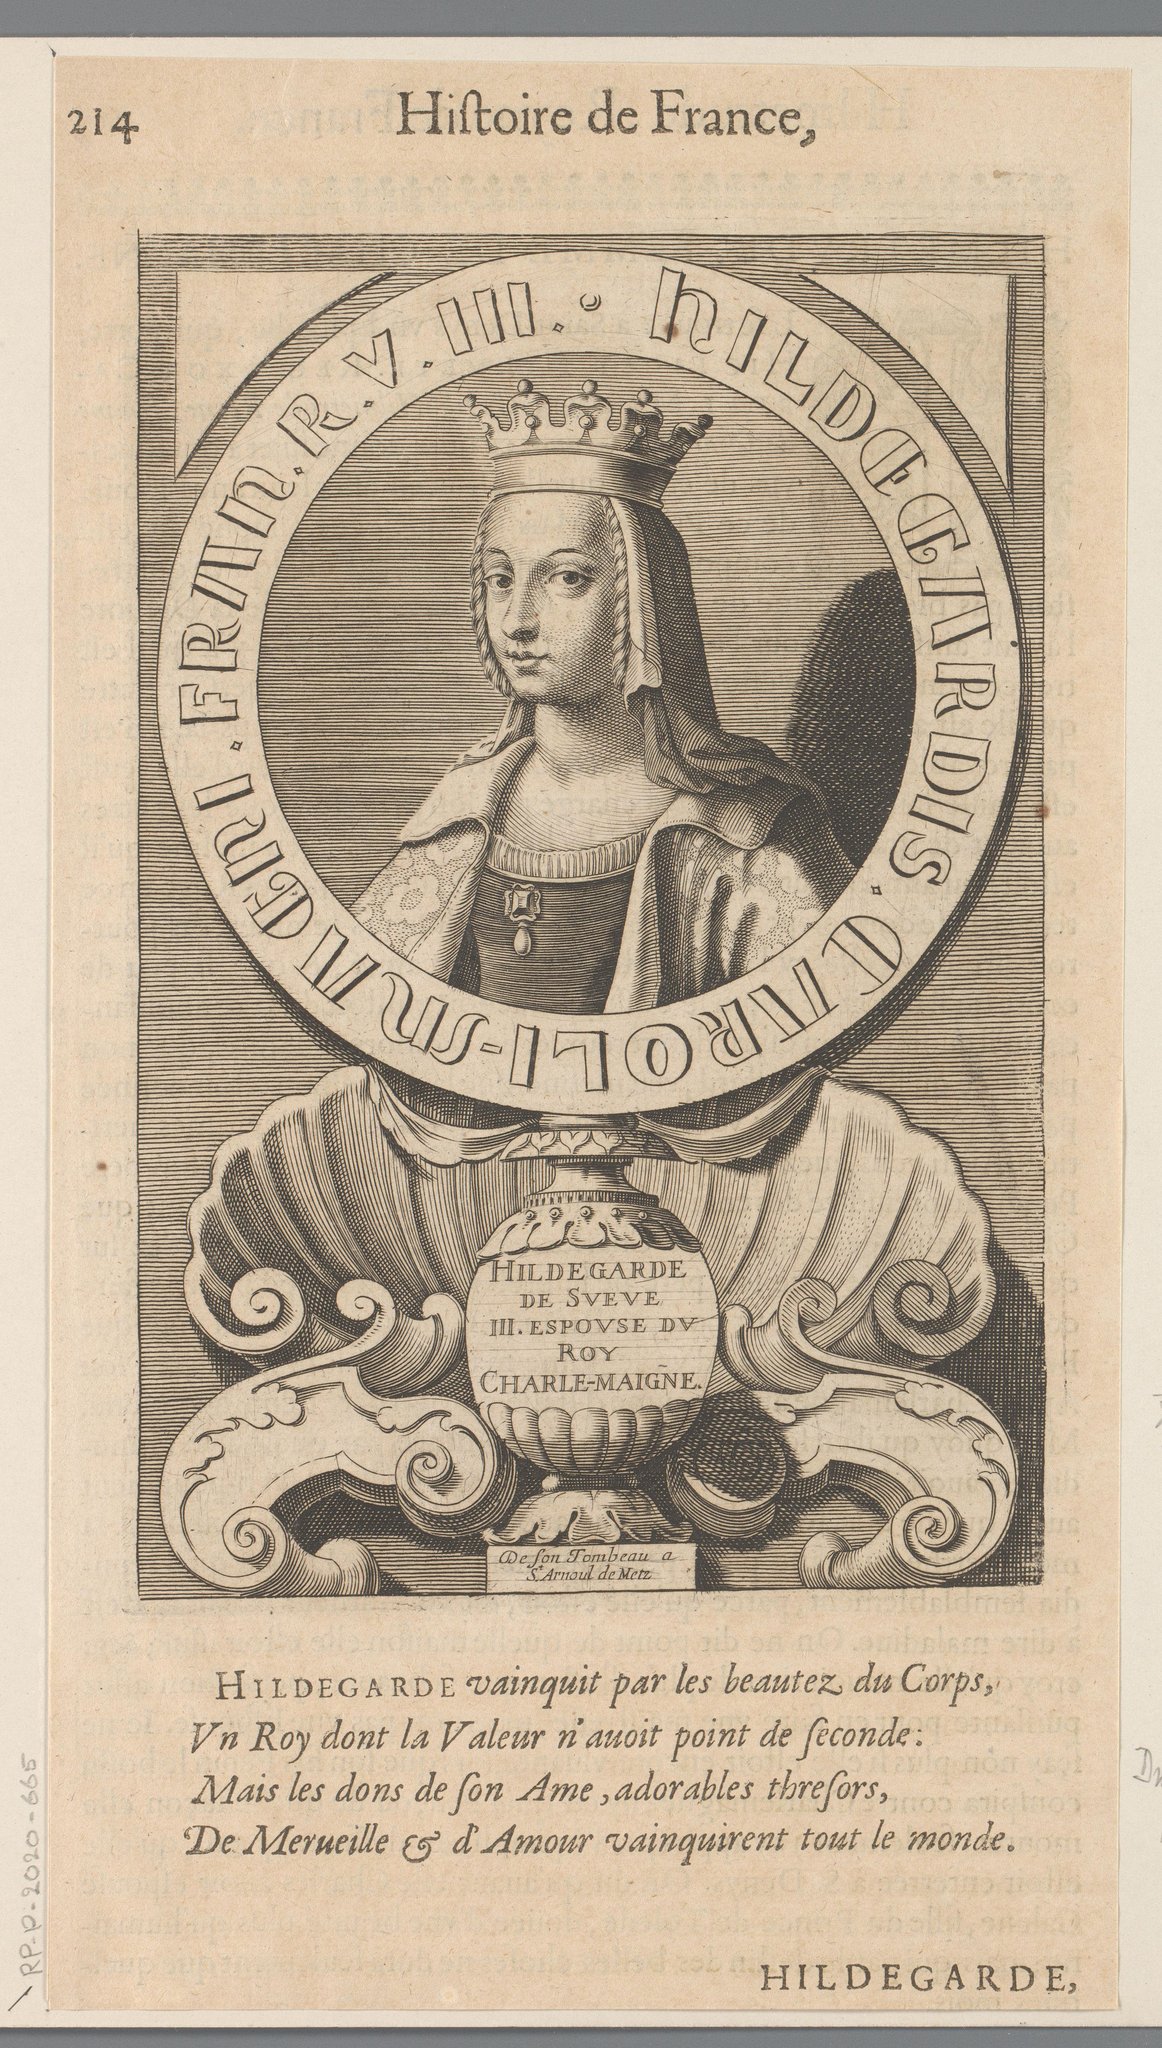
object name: book illustration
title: Portret van Hildegard, koningin der Franken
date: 1643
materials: paper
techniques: engraving, letterpress printing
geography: paris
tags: historical persons - bb - woman, queen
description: Prent uit: Eudes de Mézeray, François. Histoire de France, depuis Faramond jusqu’au regne de Louis le Juste (...). 3 dln. Parijs: Mathieu Guillemot, 1643, dl. 1. Prent waarschijnlijk voor het eerst verschenen in: Bie, Jacques de. Les vrais portraits des rois de France (...). Parijs: Jacques de Bie en Pierre Rocolet, 1634. Prent ook gebruikt in latere publicaties.